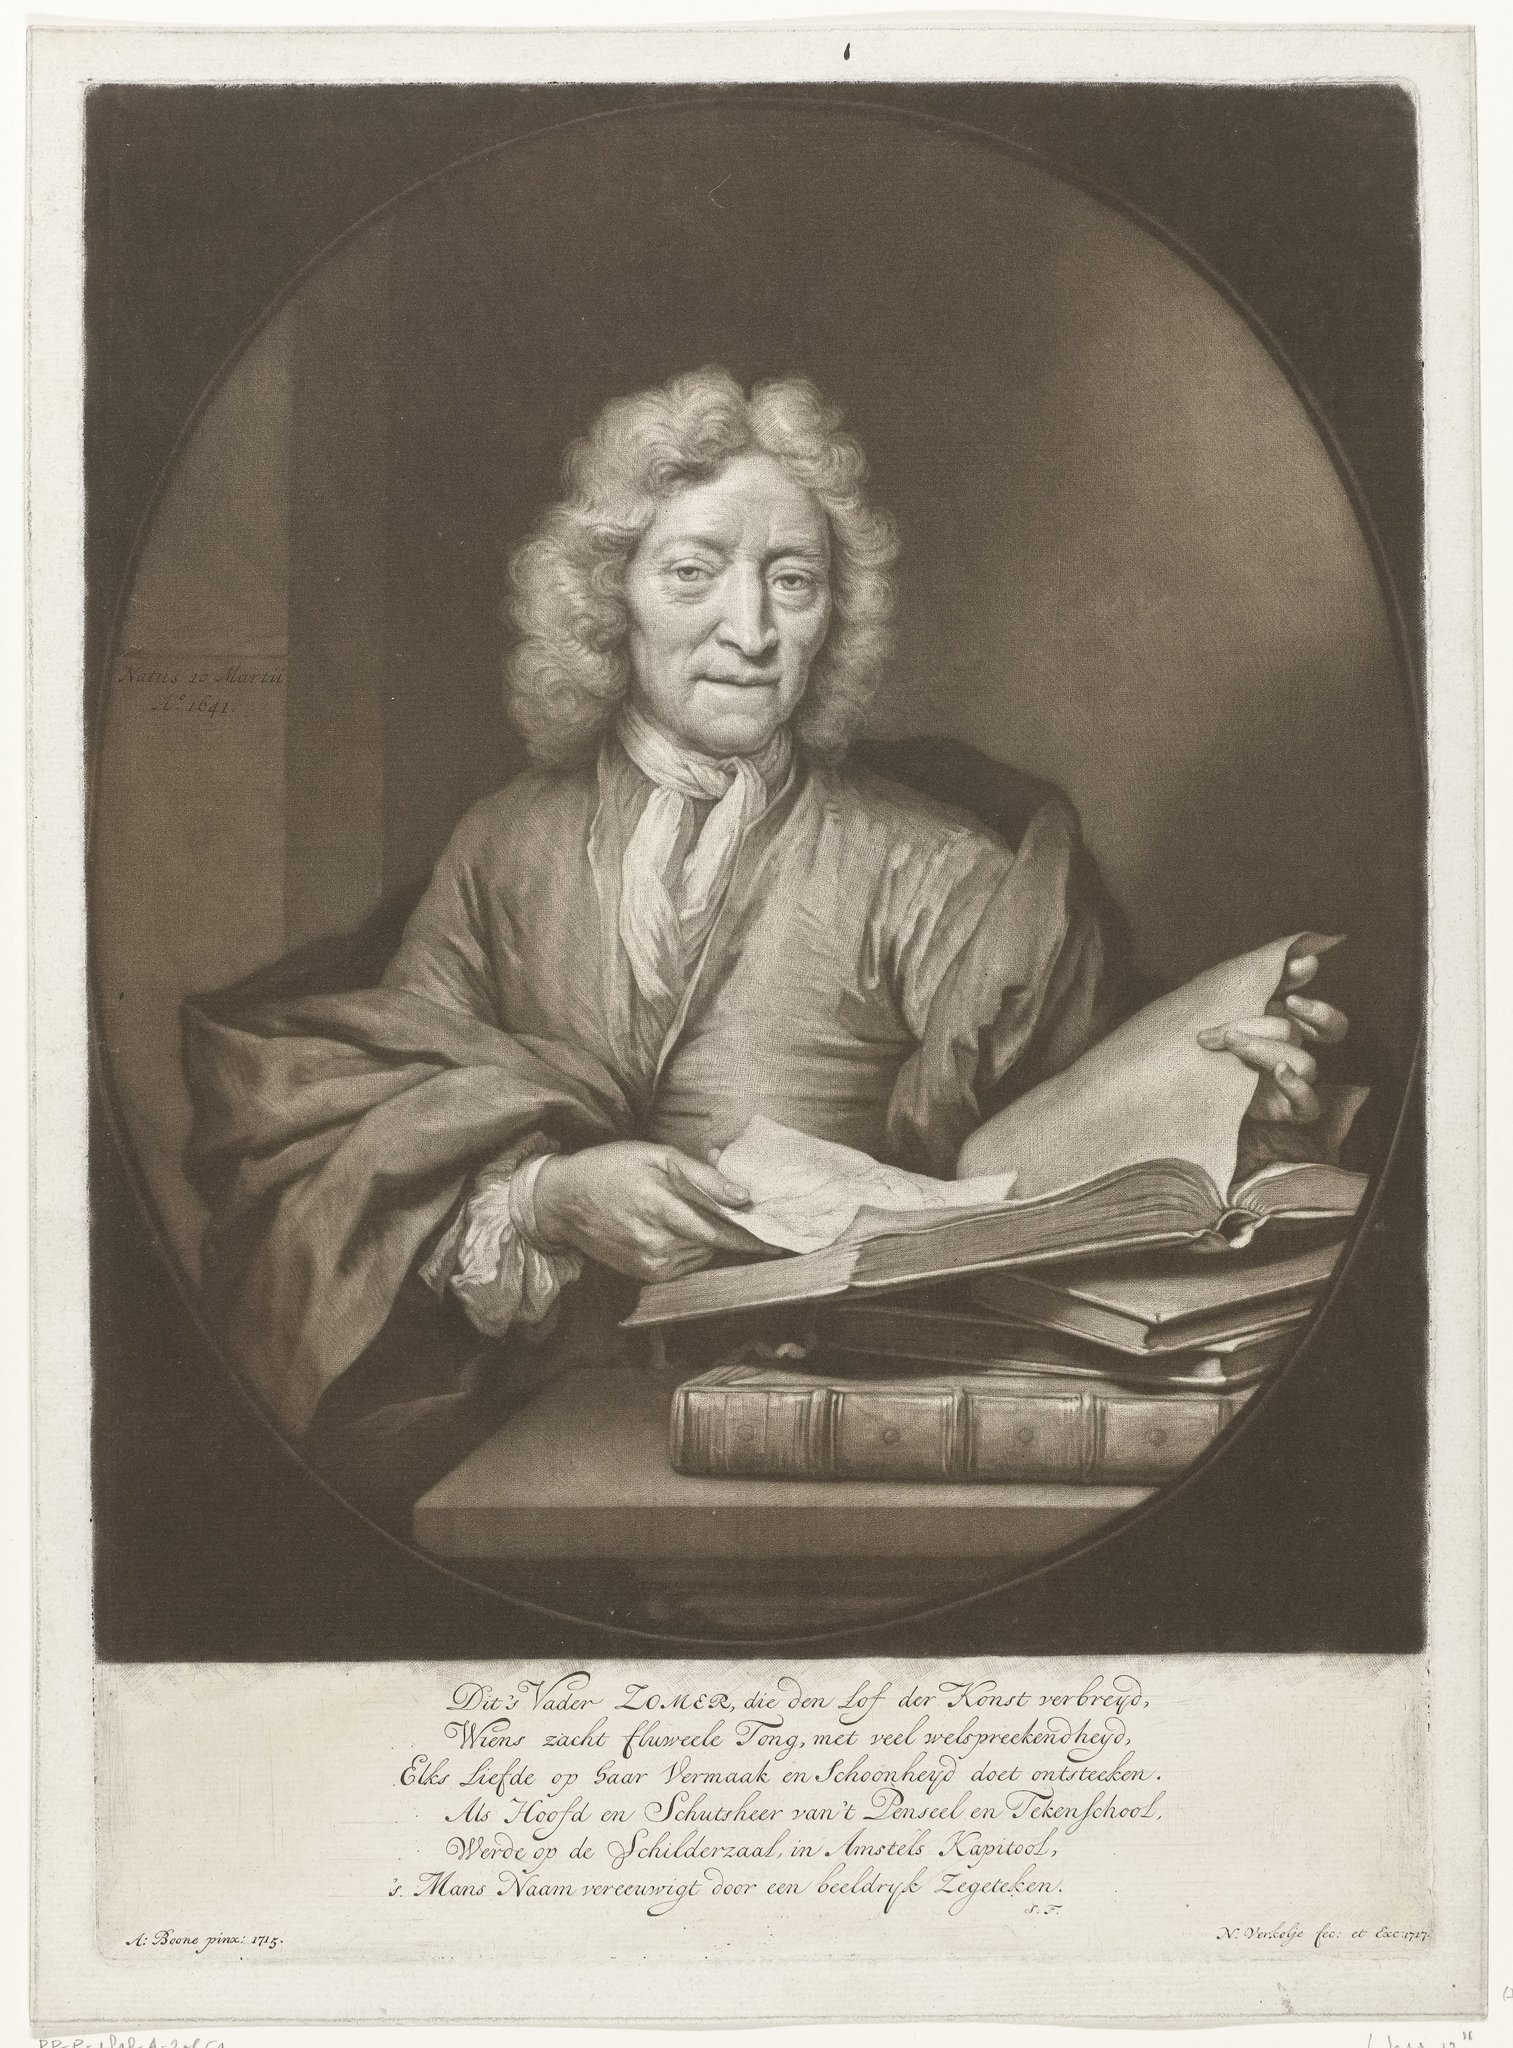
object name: print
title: Portret van Jan Pietersz. Zomer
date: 1717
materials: paper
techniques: engraving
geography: amsterdam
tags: amsterdam, draughtsman, jan pietersz. zomer, print, e.g.: engraving, etching, lithograph, art dealer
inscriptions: collector's mark: Lugt 964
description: De kunsthandelaar Jan Pietersz. Zomer, zit aan een tafel en toont een afbeelding in een opengeslagen album. In de marge een lofdicht op zijn welbespraaktheid en kwaliteiten als kunsthandelaar.